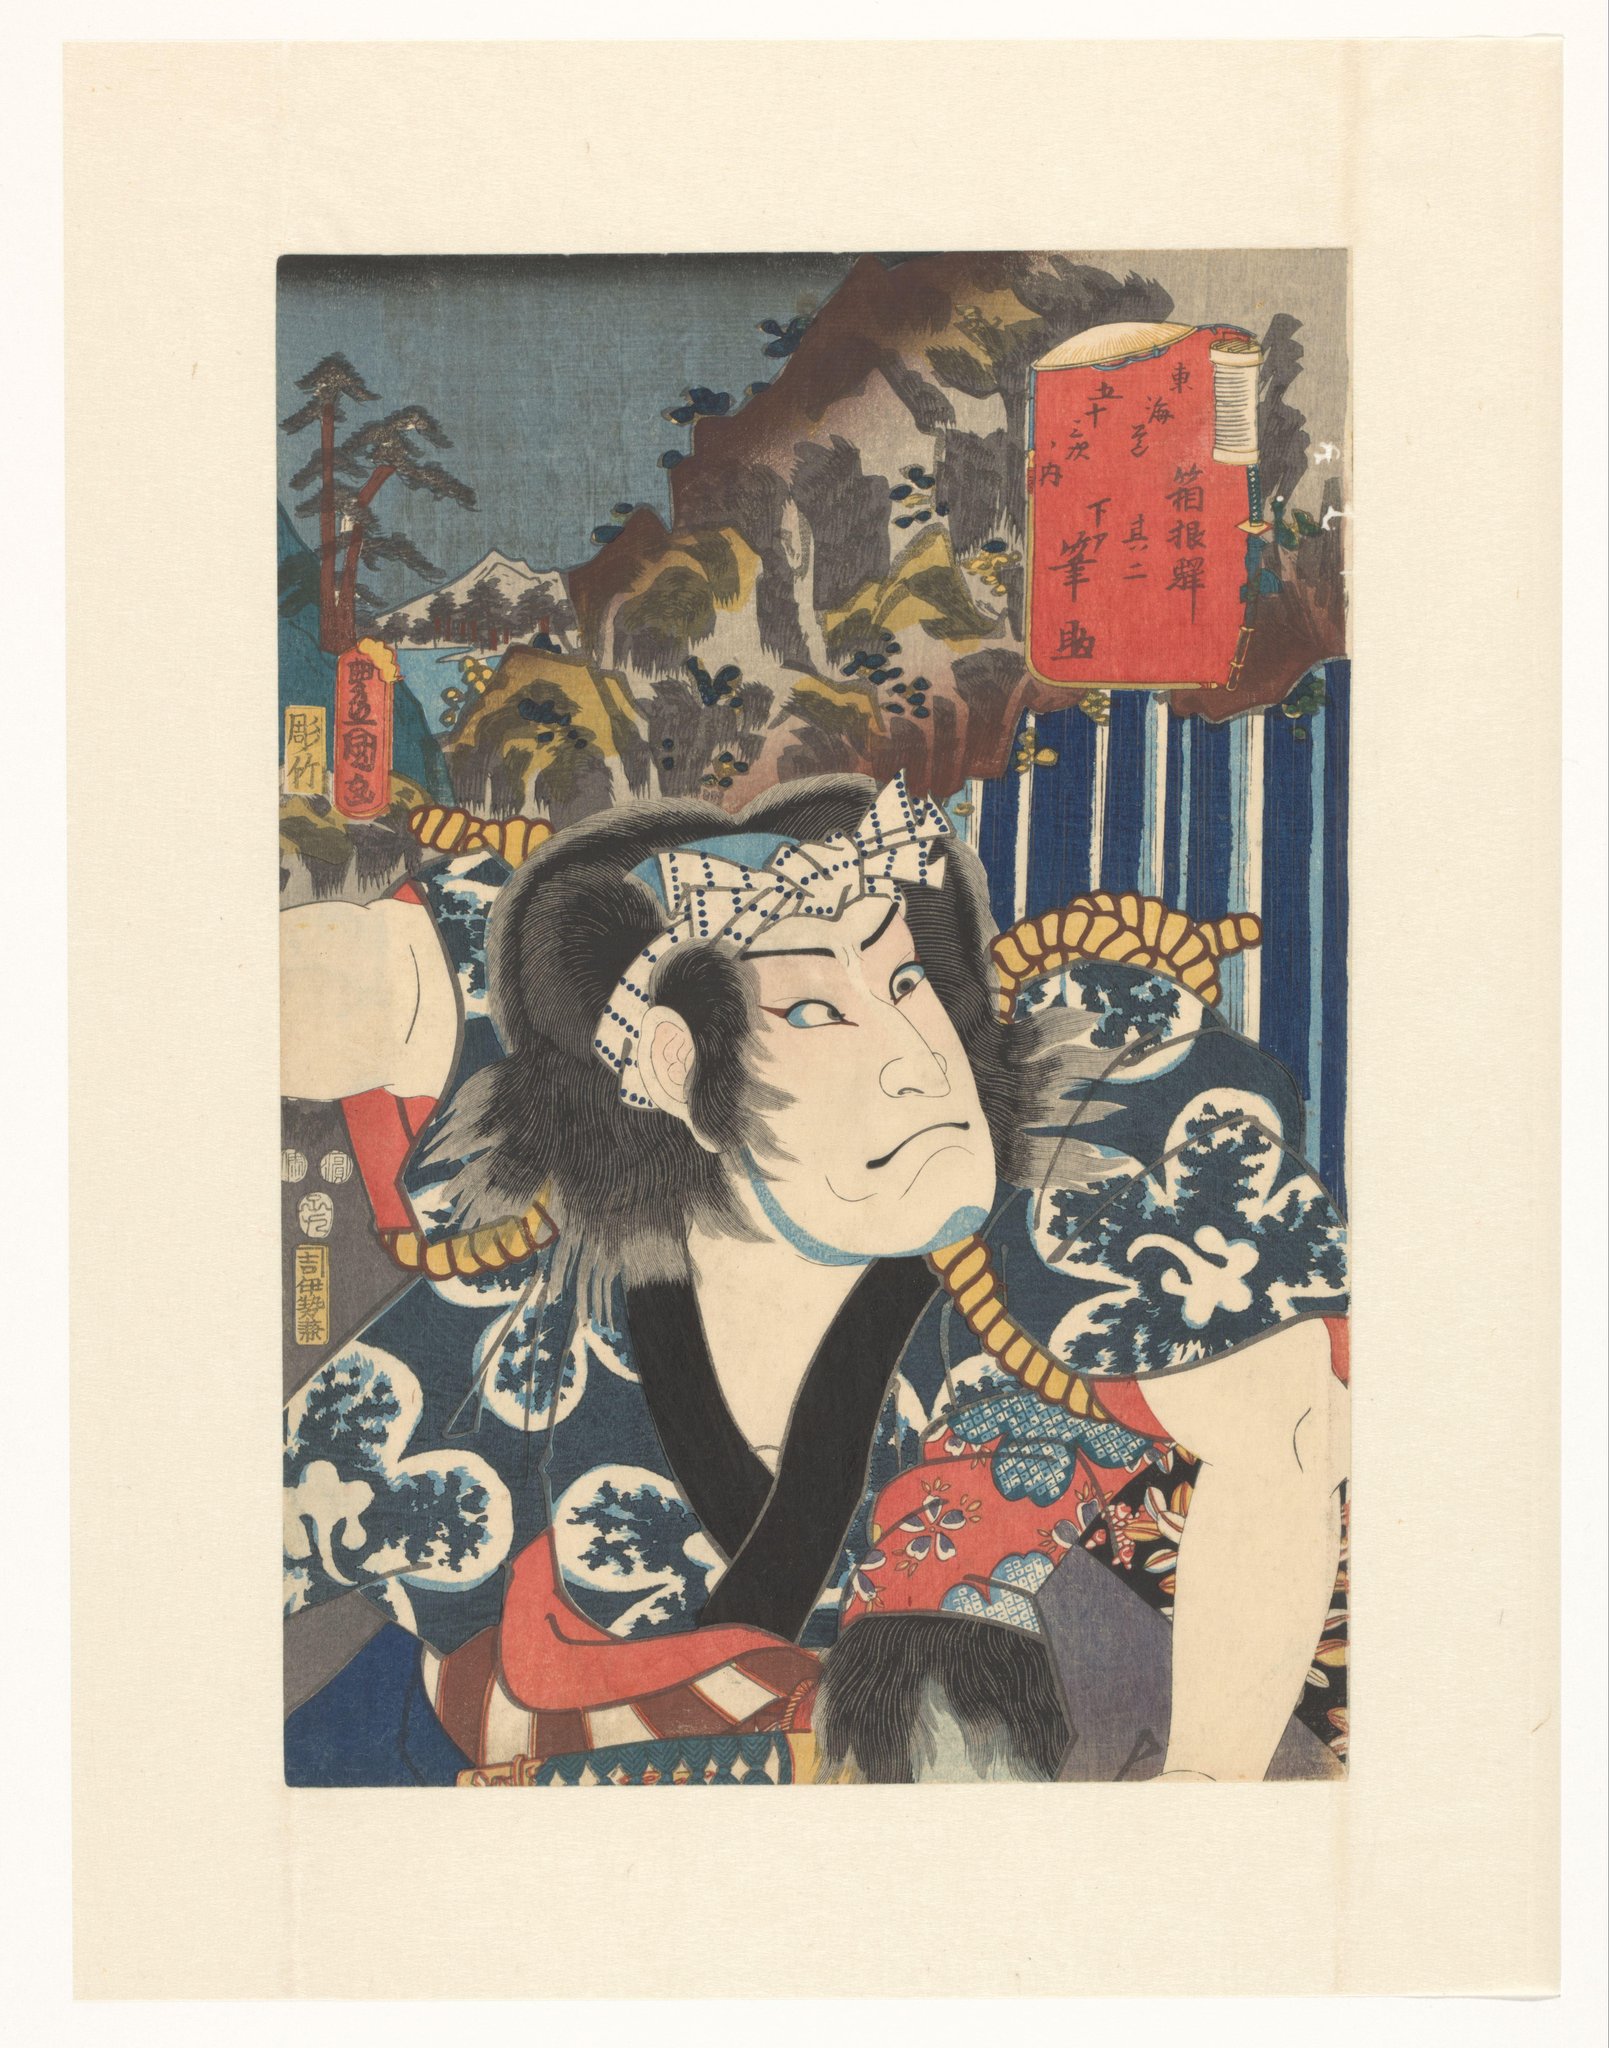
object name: print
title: Hakone station, second (design) - servant Fudesuke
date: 1809-1852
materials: paper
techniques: woodcut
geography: japan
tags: waterfall, actor (on the stage), head of a beheaded person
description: Kabuki acteur Nakamura Utaemon IV in de rol van de dienstbode Fudesuke, met in zijn handen het hoofd van zijn zus Hatsuhana, ingepakt in lappen en waarvan alleen een stuk haar te zien is. Met de touwen rond zijn schouders zijn de mouwen van zijn kimono opgebonden, zodat hij makkelijker kan bewegen; een aanwijzing dat hij gereed is om te vechten. Op de achtergrond de Shirataki waterval in de bergen van Hakone, waar zijn zus gevangen en onthoofd werd.